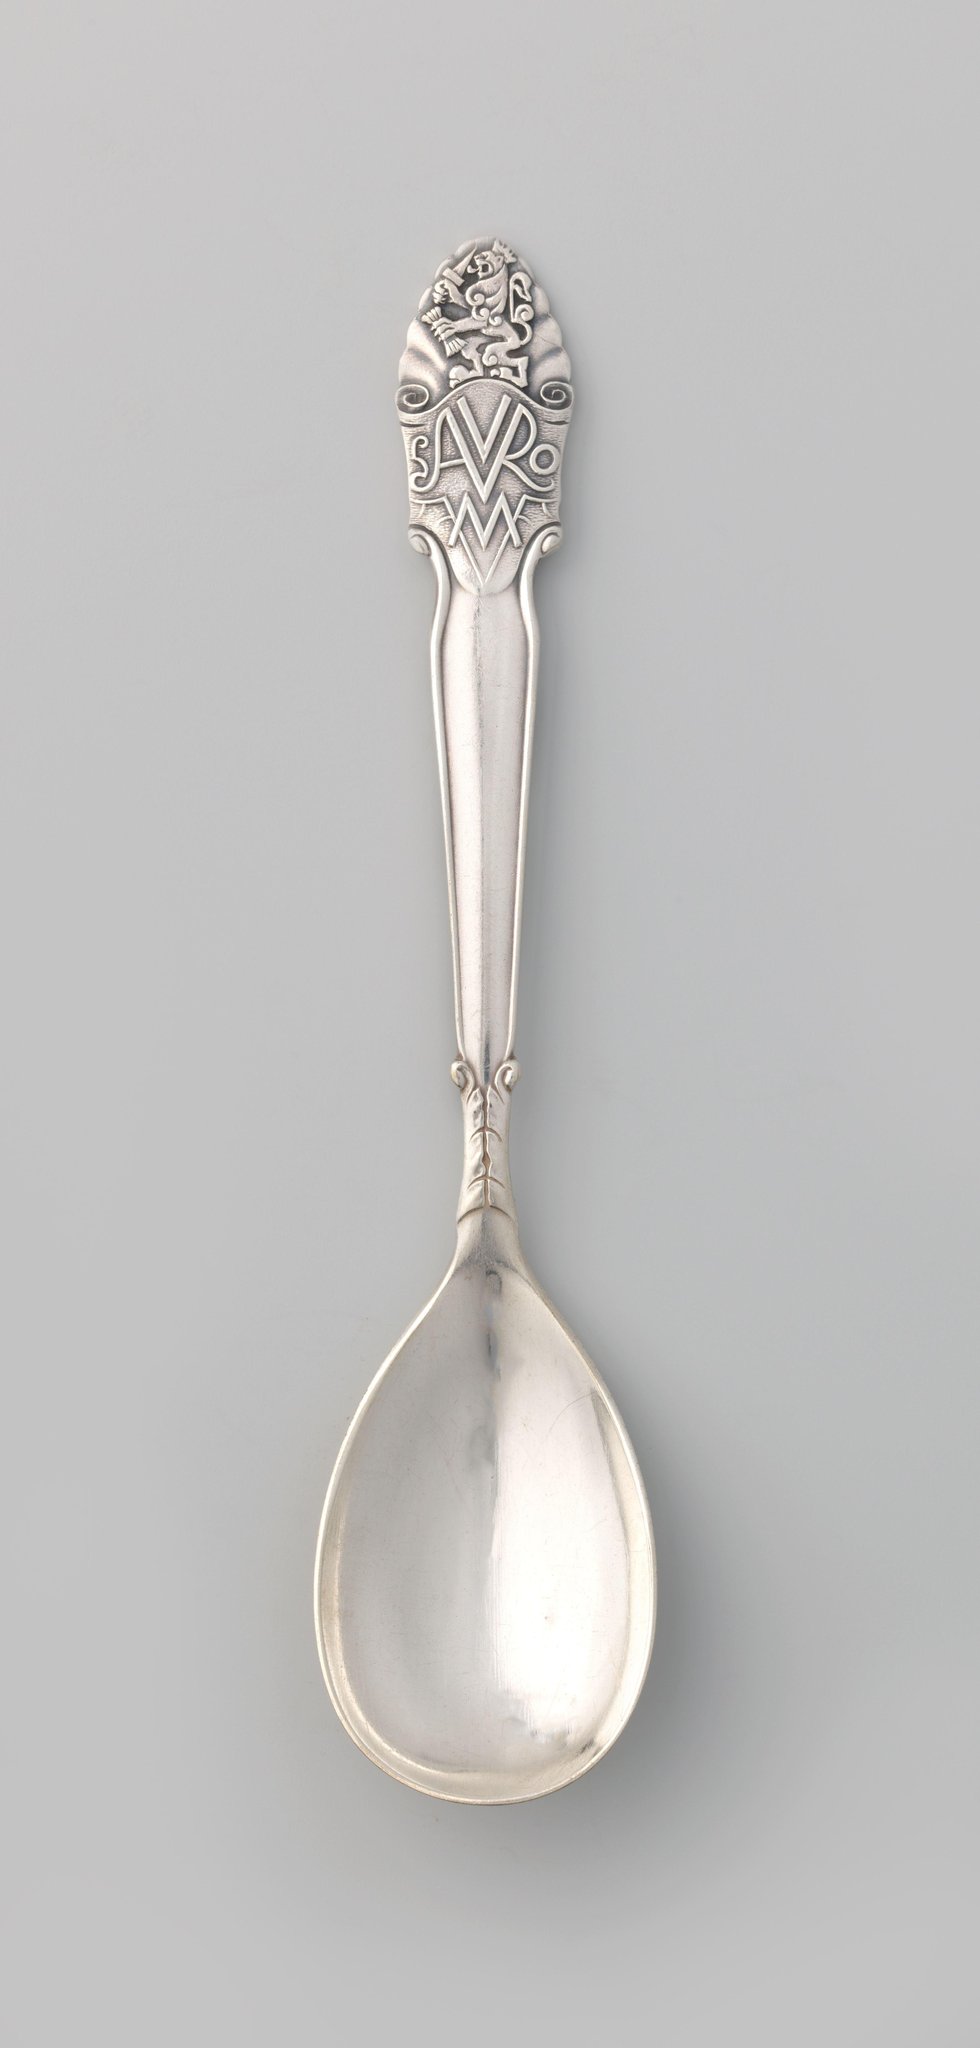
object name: pap spoon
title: Paplepel AVRO, zomer 1934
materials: metal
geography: zeist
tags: netherlands